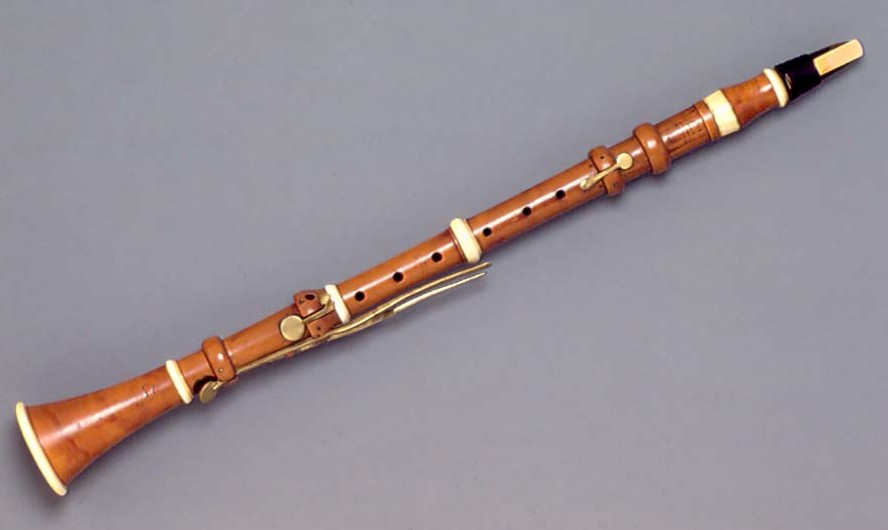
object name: clarinet in b flat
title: Clarinet in B-flat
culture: american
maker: graves & company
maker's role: maker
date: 1830-1840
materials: wood, brass, ivory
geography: united states